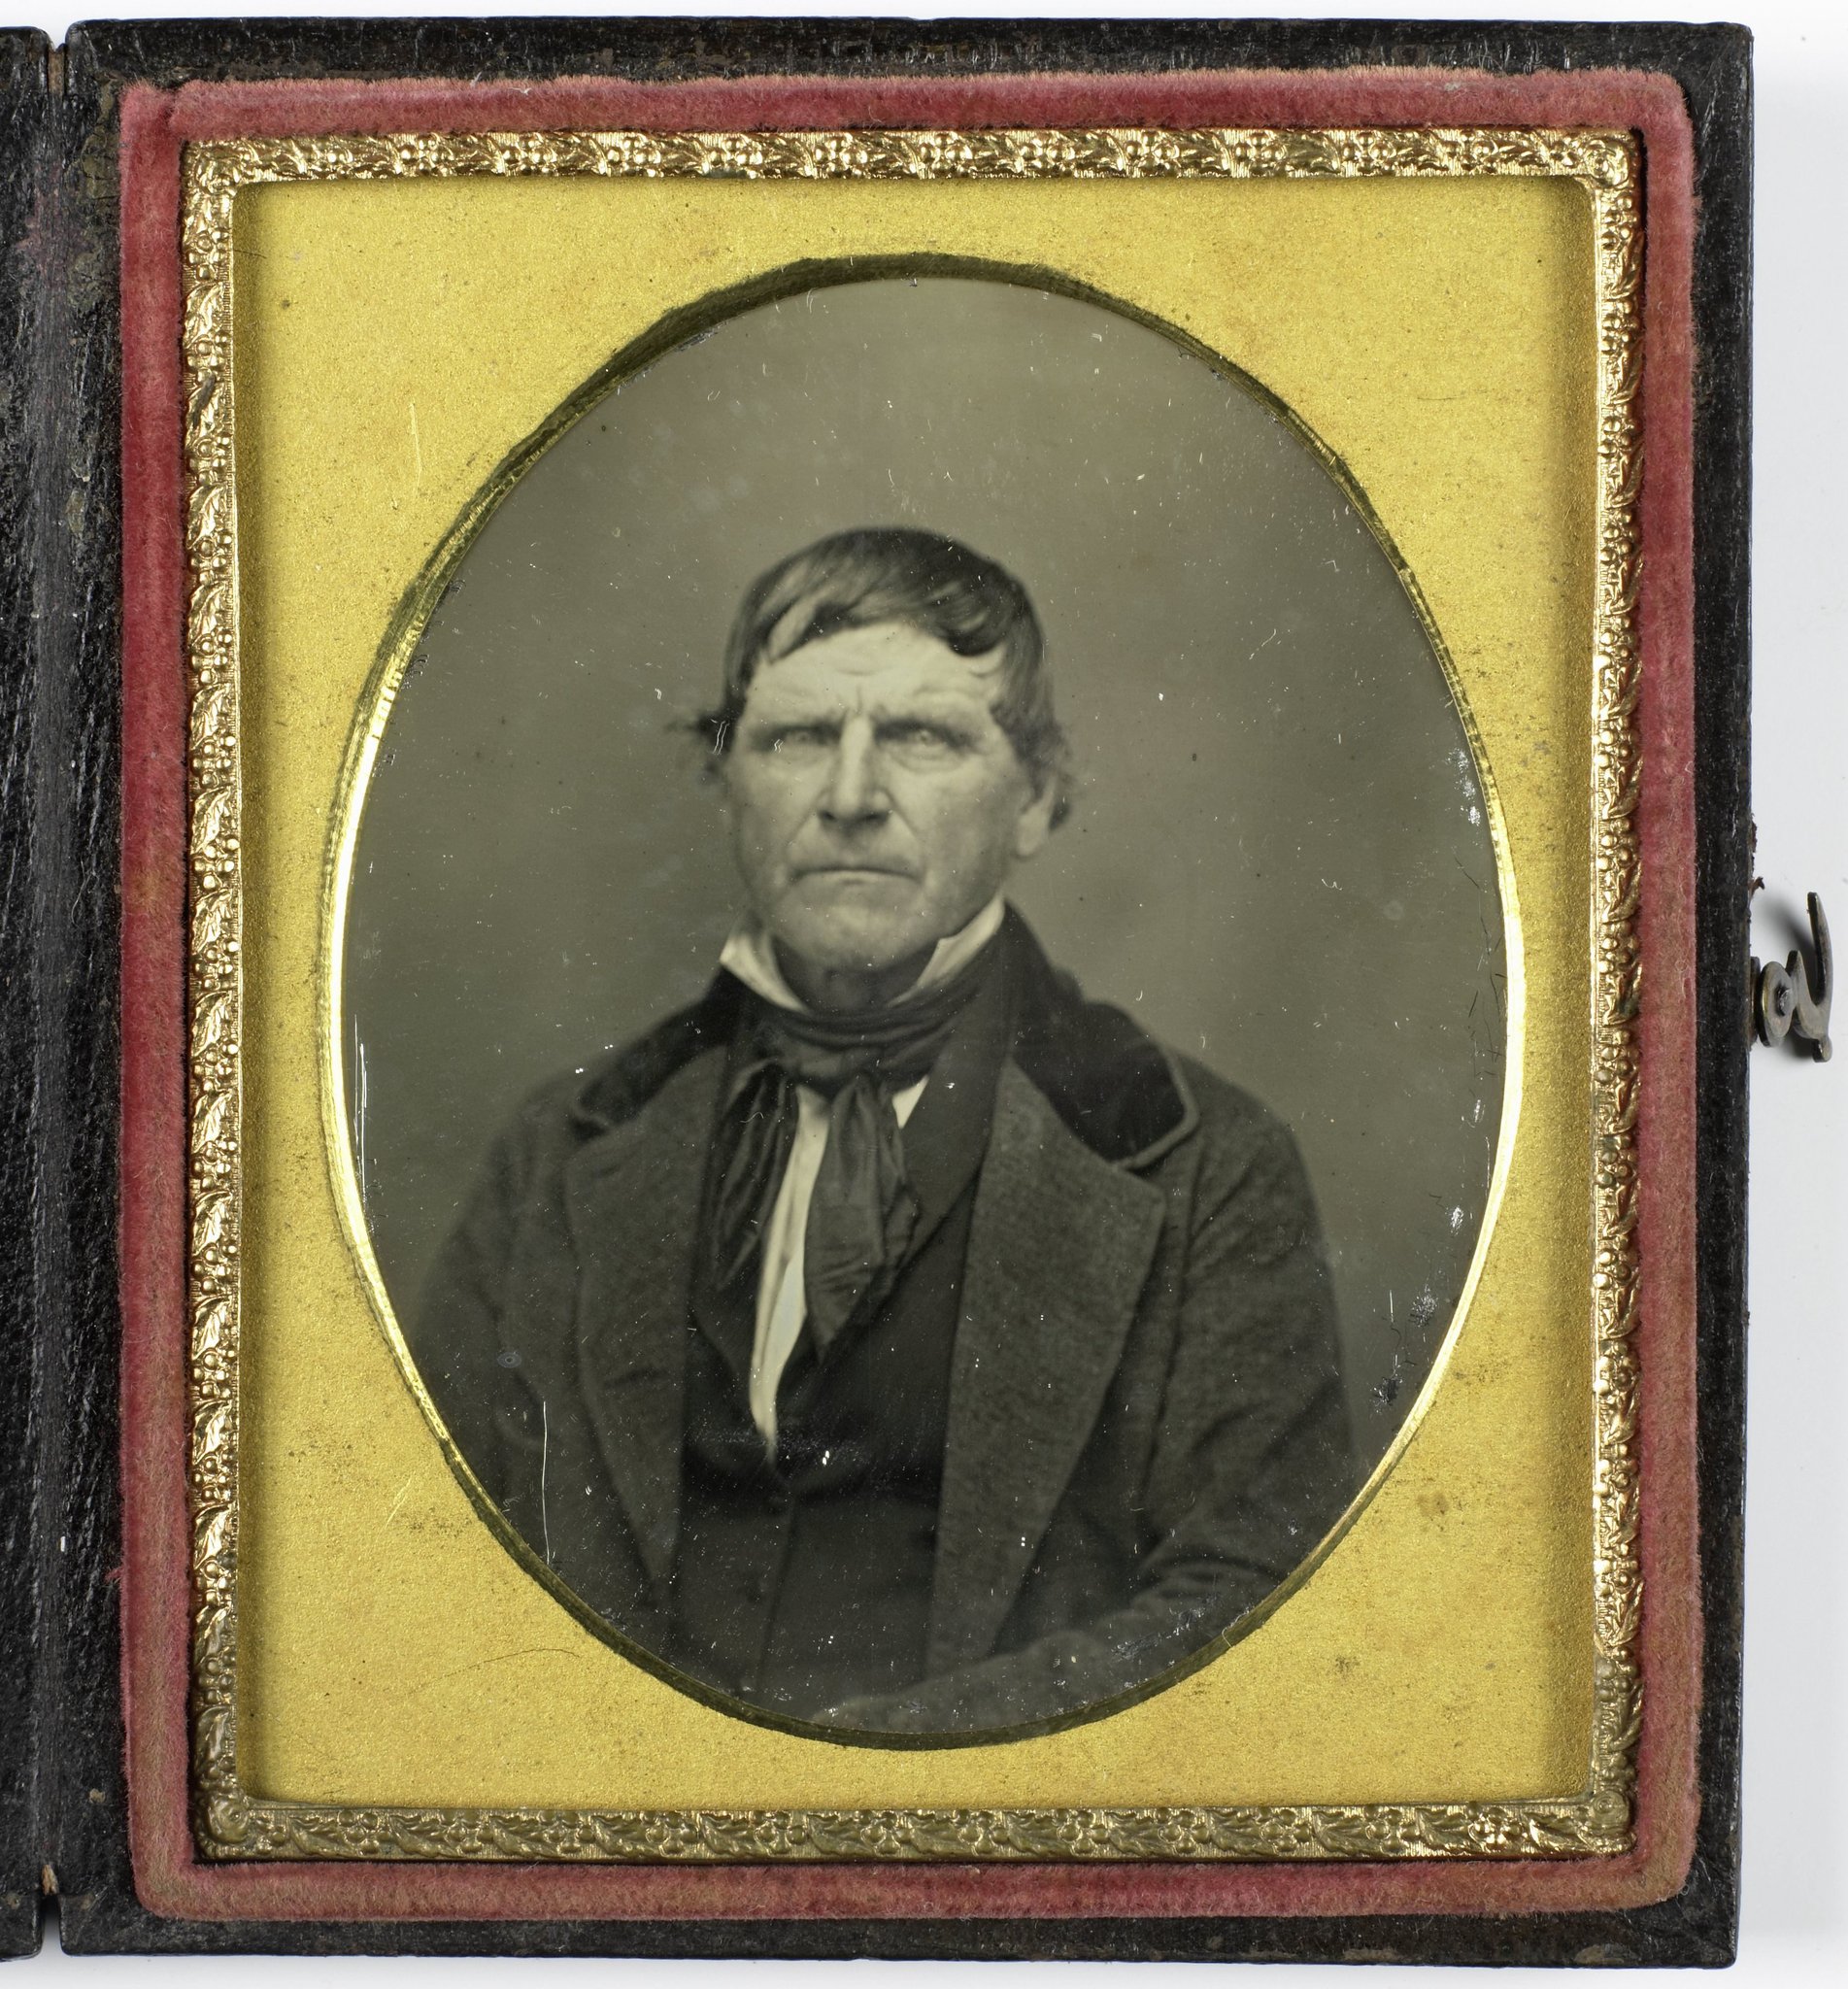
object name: photograph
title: Portret van een onbekende man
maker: Anonymous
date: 1851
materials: copper, glass, leather, velvet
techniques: daguerreotype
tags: adult man, historical persons